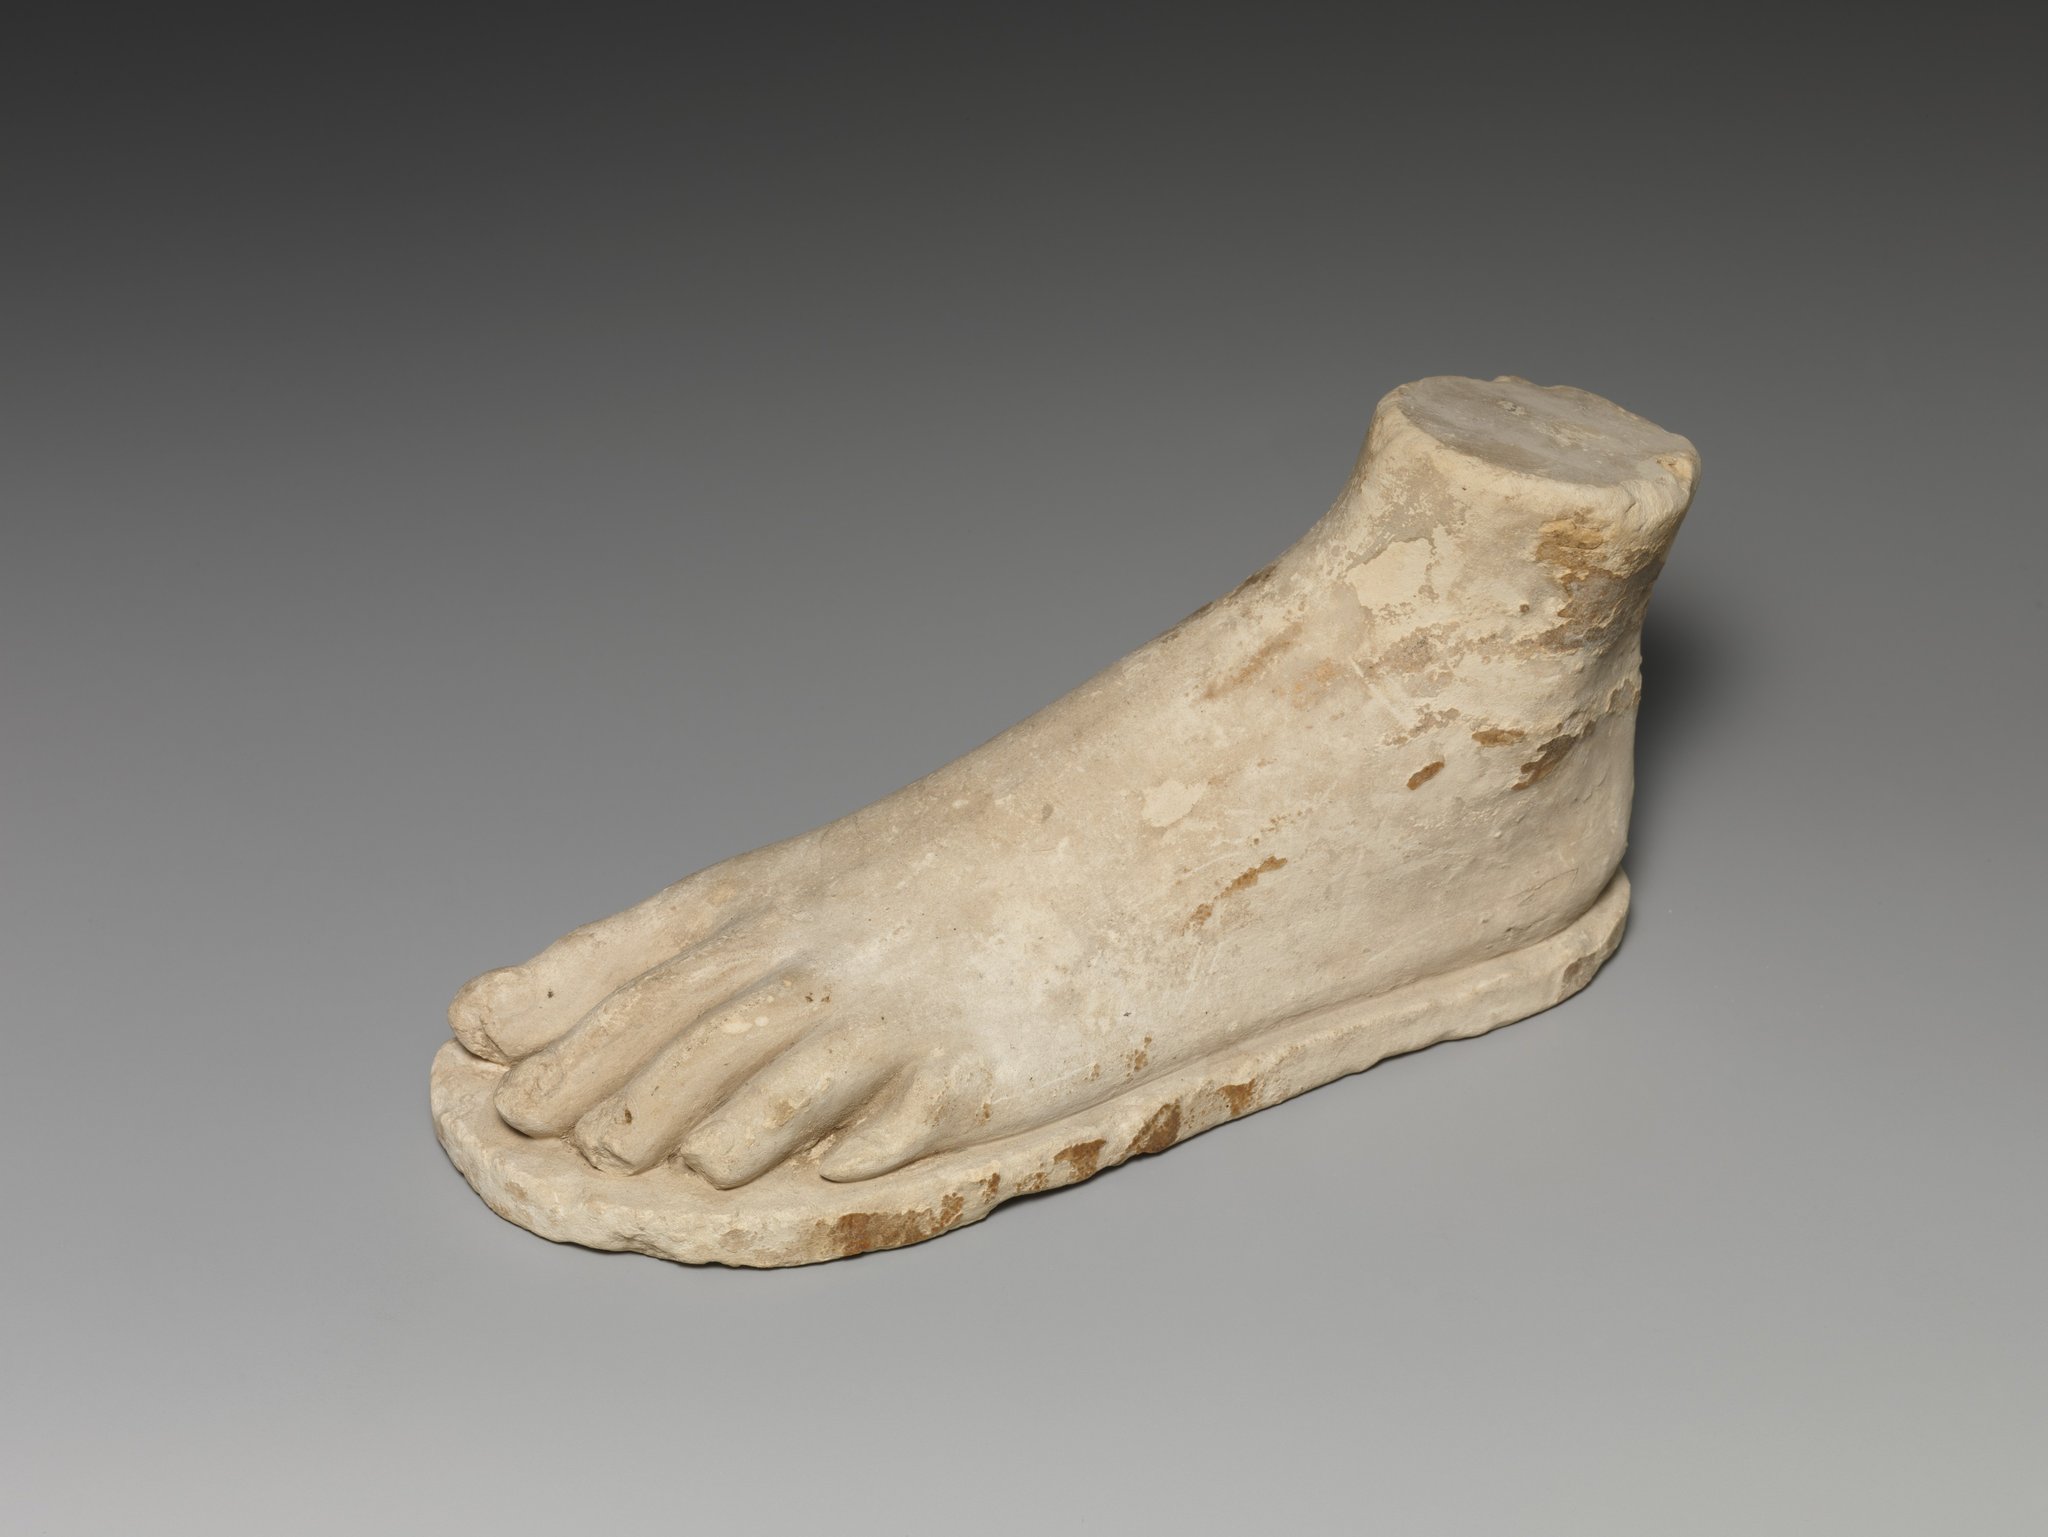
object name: sculptor's model votive, foot, left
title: Left foot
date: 400-30 BCE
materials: limestone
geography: egypt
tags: feet